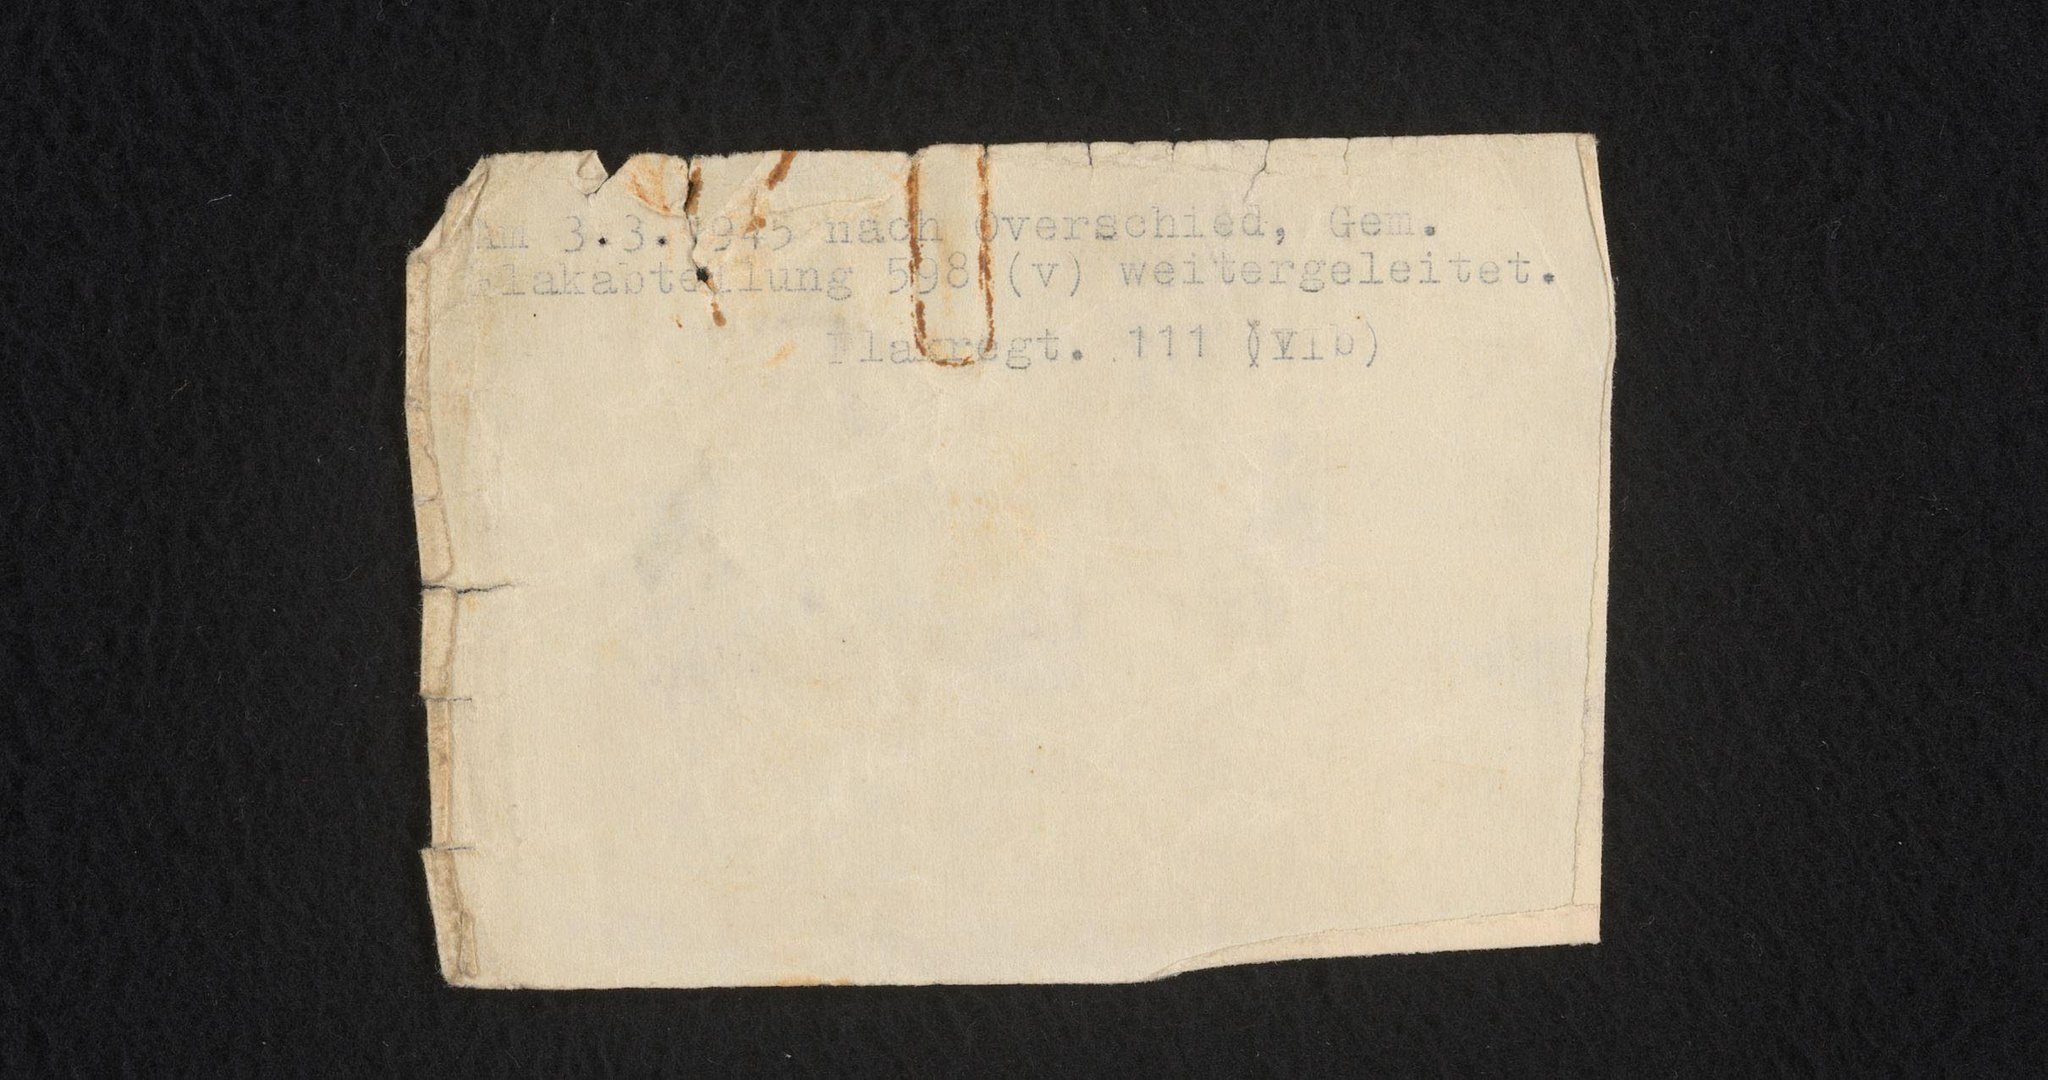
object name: document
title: Reisdocument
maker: Anonymous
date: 1945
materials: paper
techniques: typewriting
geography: germany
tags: communication and transport, the soldier; the soldier's life, netherlands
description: Briefje, mogelijk behorend bij een reisdocument van Hans Heineman, gedateerd 3 maart 1945. Document in melinexmapje los in de doos bij het fotoalbum 'Kriegszeit in Holland' over de diensttijd in Nederland van Hans Heinemann van een Flak Regiment van de Luftverteidigungskommando van de Luftwaffe.